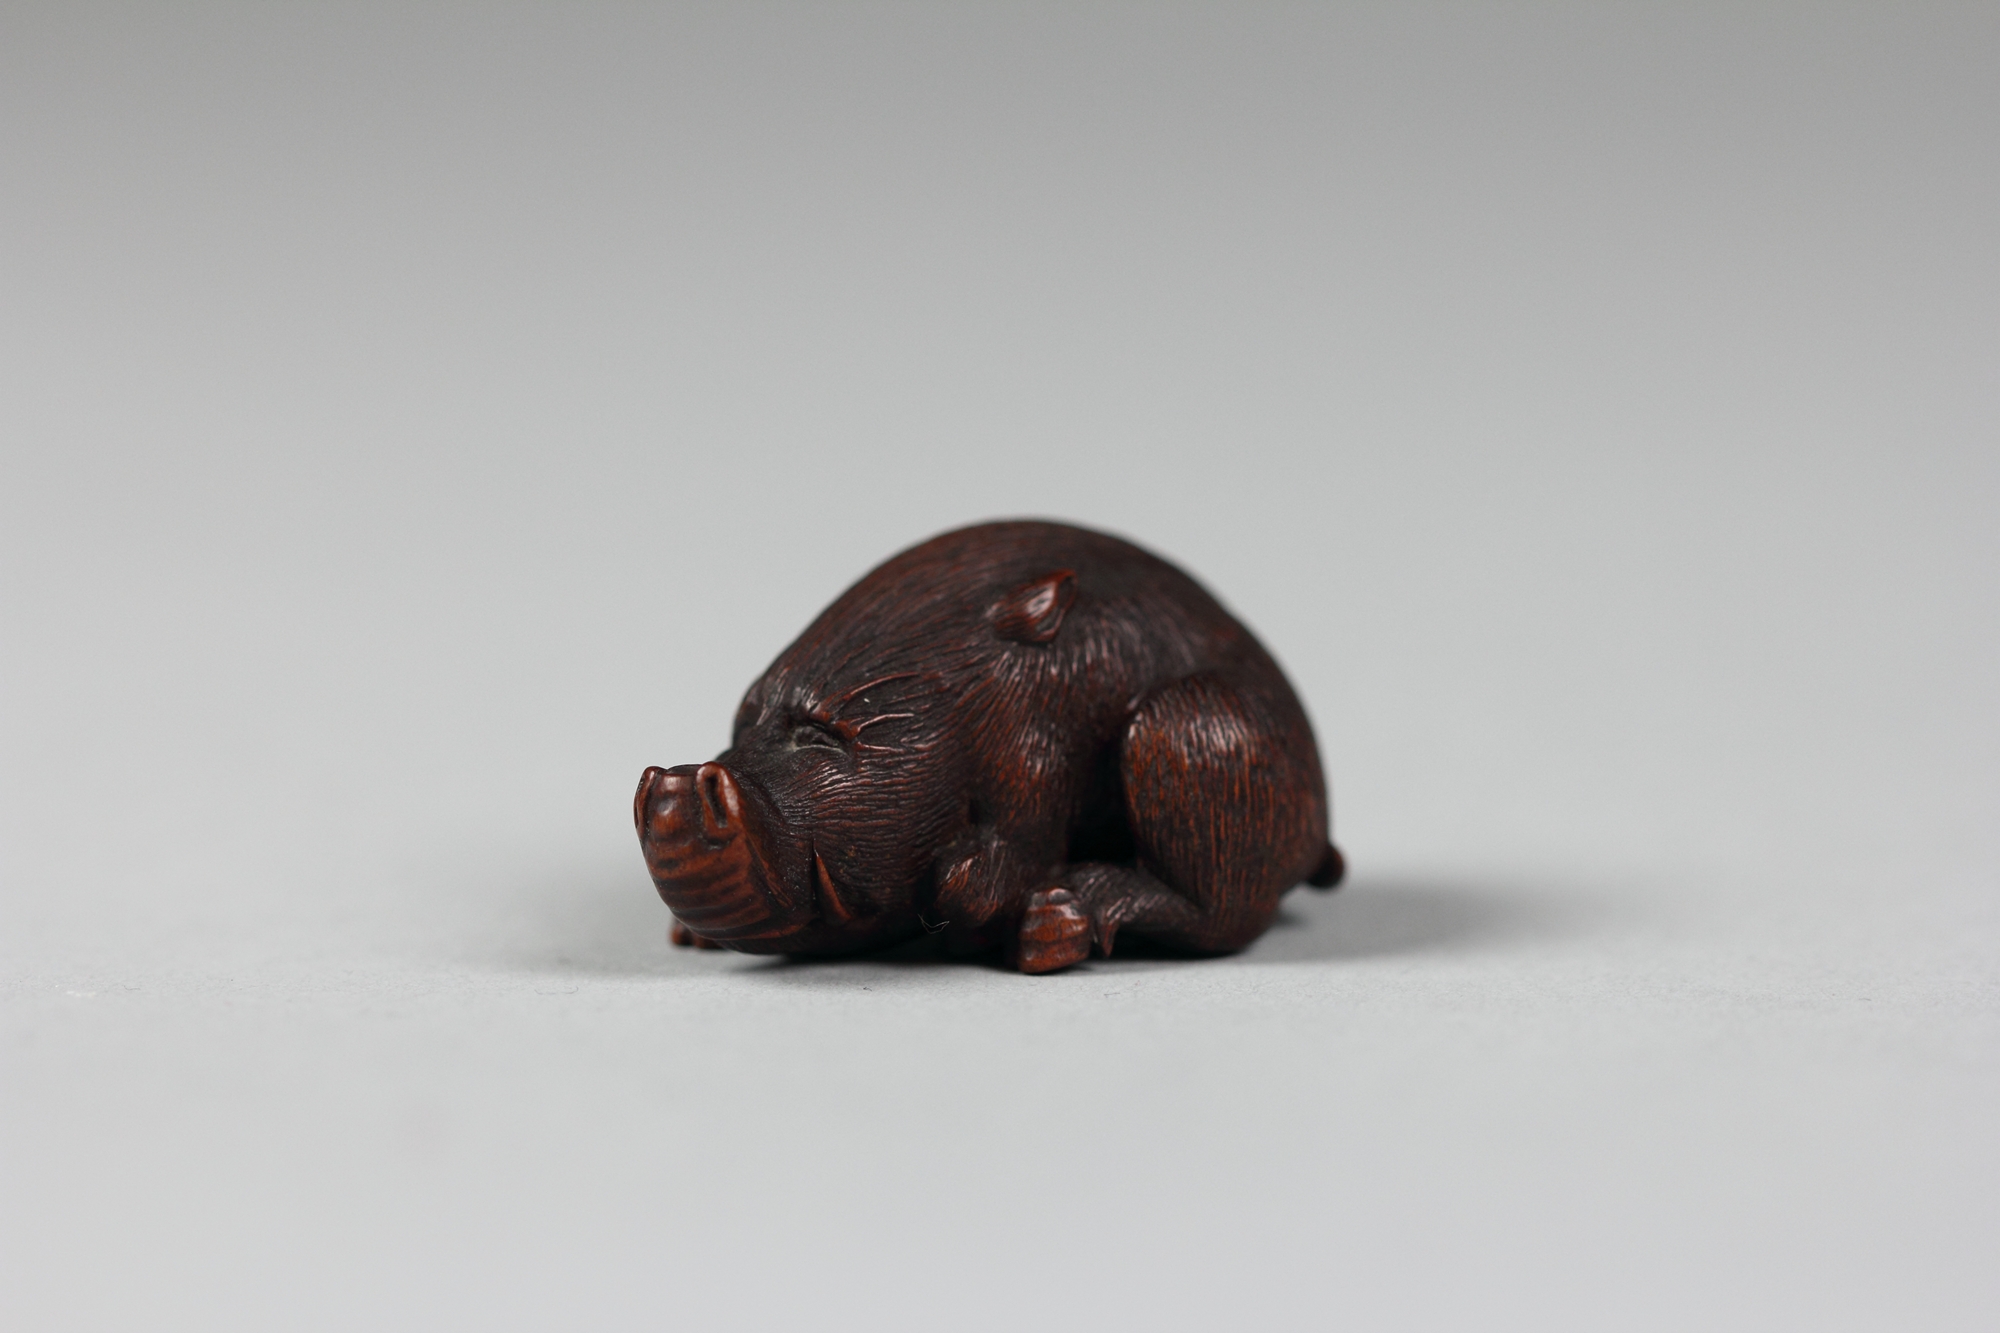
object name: netsuke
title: Netsuke of Boar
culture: japanese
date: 1801-1900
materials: wood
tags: boars